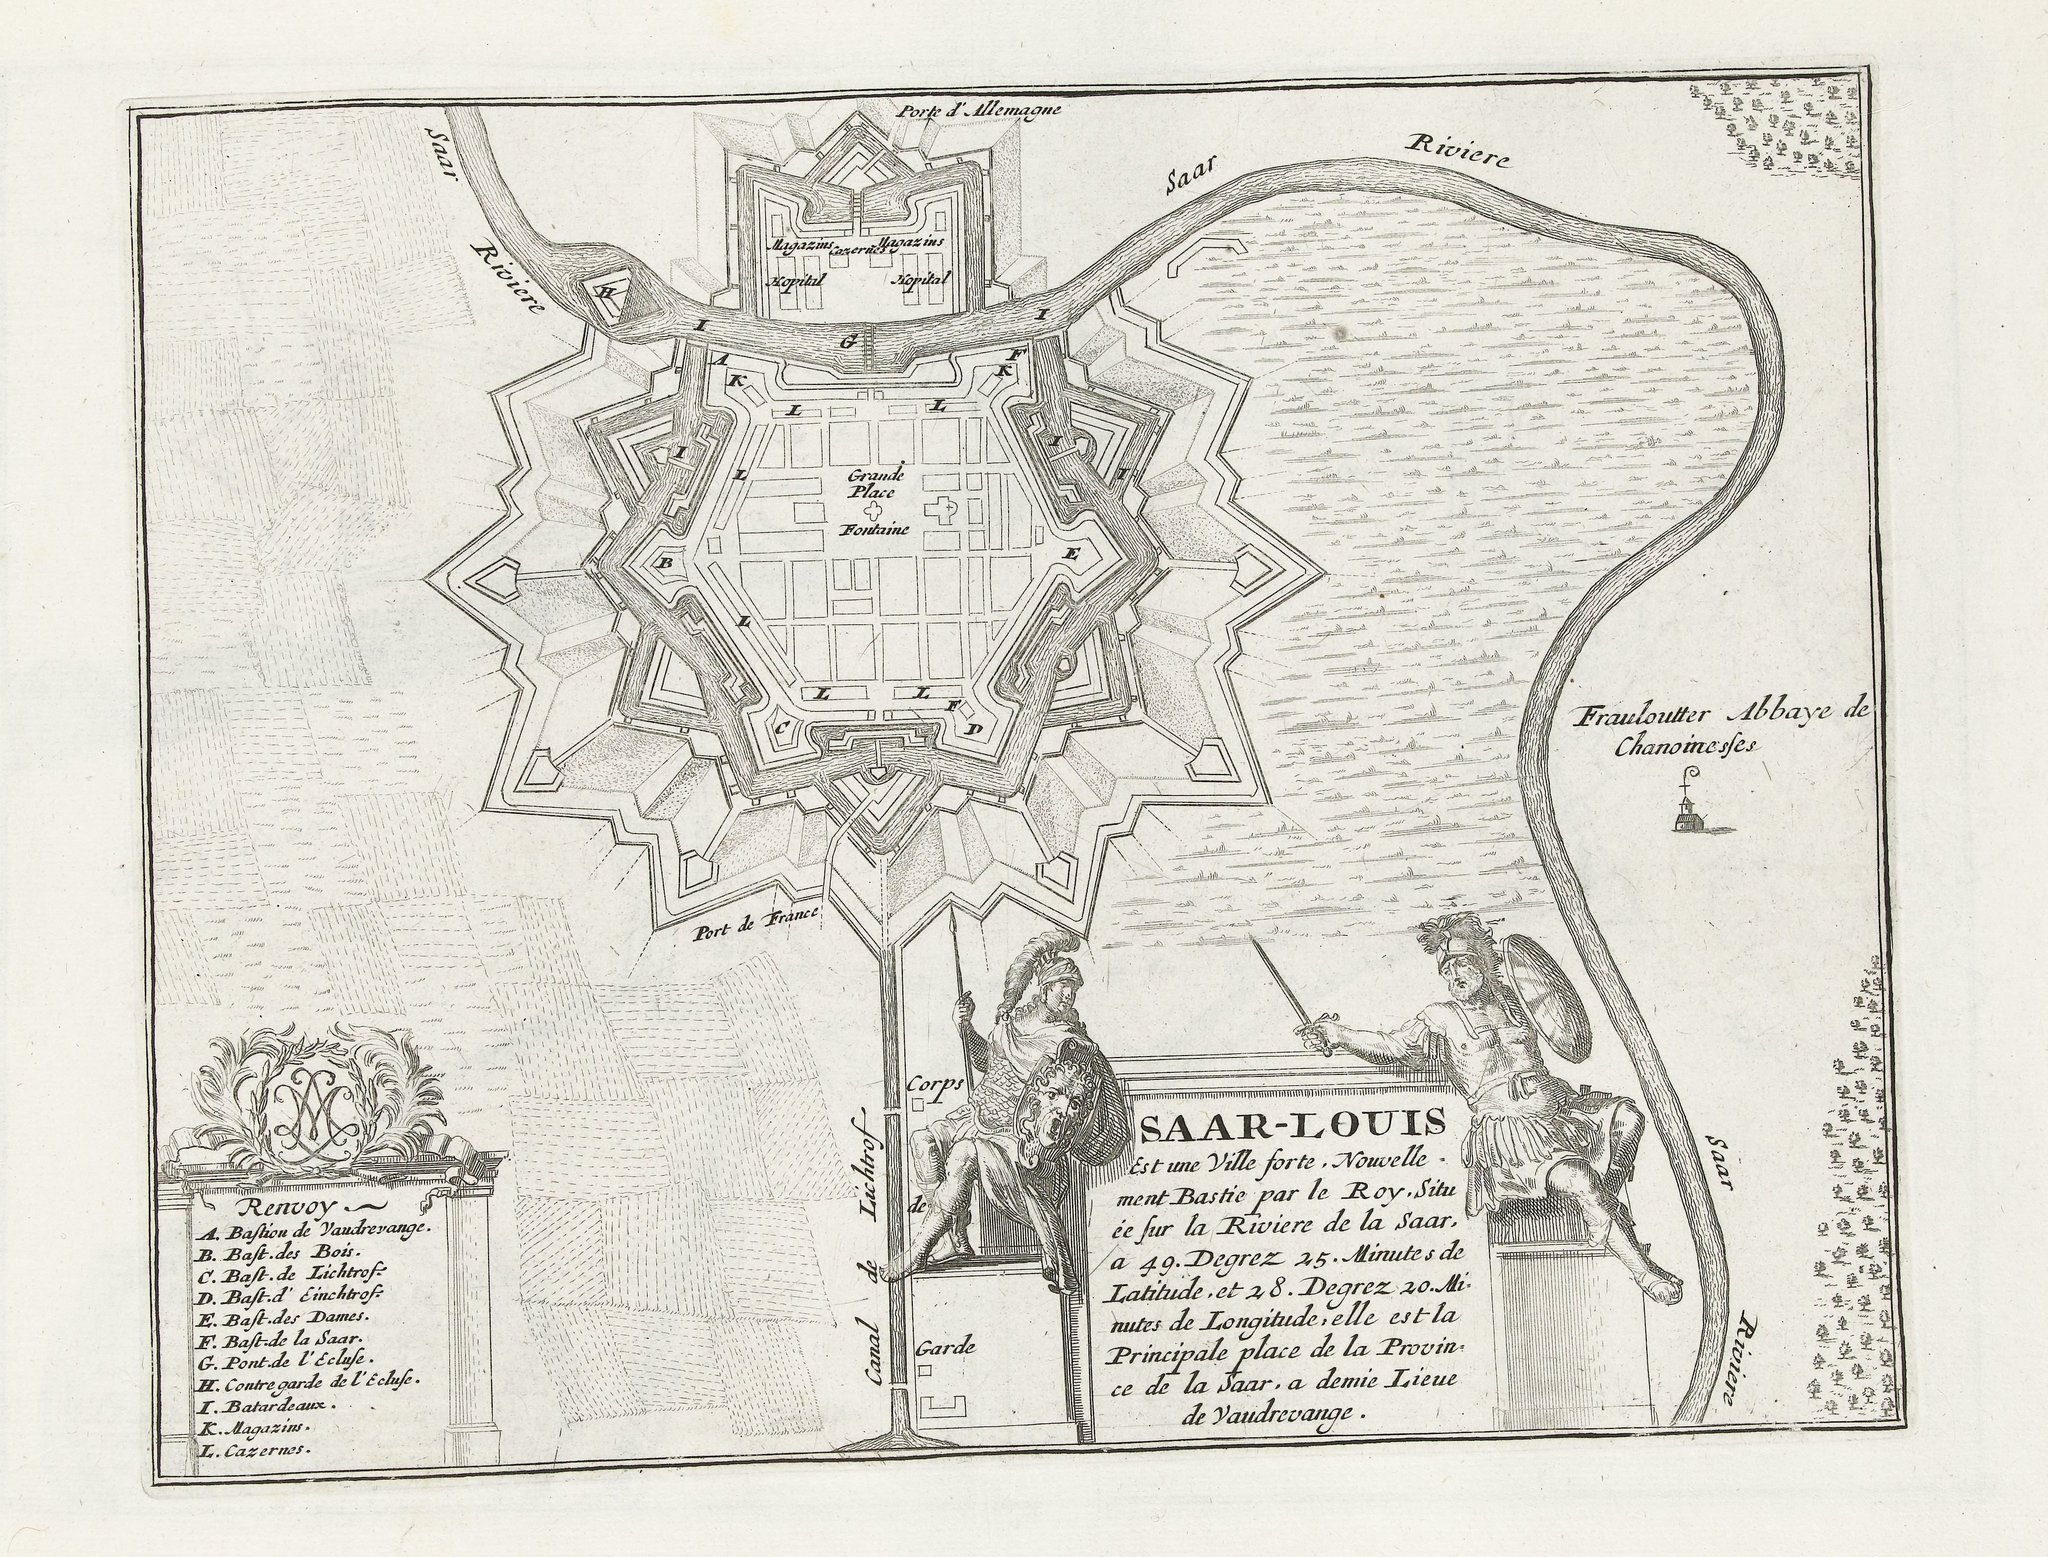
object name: print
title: Plattegrond van Saarlouis, ca. 1693-1695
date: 1693-1695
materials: paper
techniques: etching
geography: france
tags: fortress, maps of cities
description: Plattegrond van de versterkingen om de Franse stad Saarlouis. Onderdeel van het derde deel (1695) van het prentwerk waarin gebundeld zijn de acht delen van Les forces de l'Europe uitgegeven tussen 1693-1697. Het prentwerk bestaat uit 175 platen met plannen (afkomstig van Sébastien Le Prestre, Seigneur de Vauban) van vermaarde sterke steden en vestingen in de Negenjarige Oorlog. Titel en opschriften in het Frans.